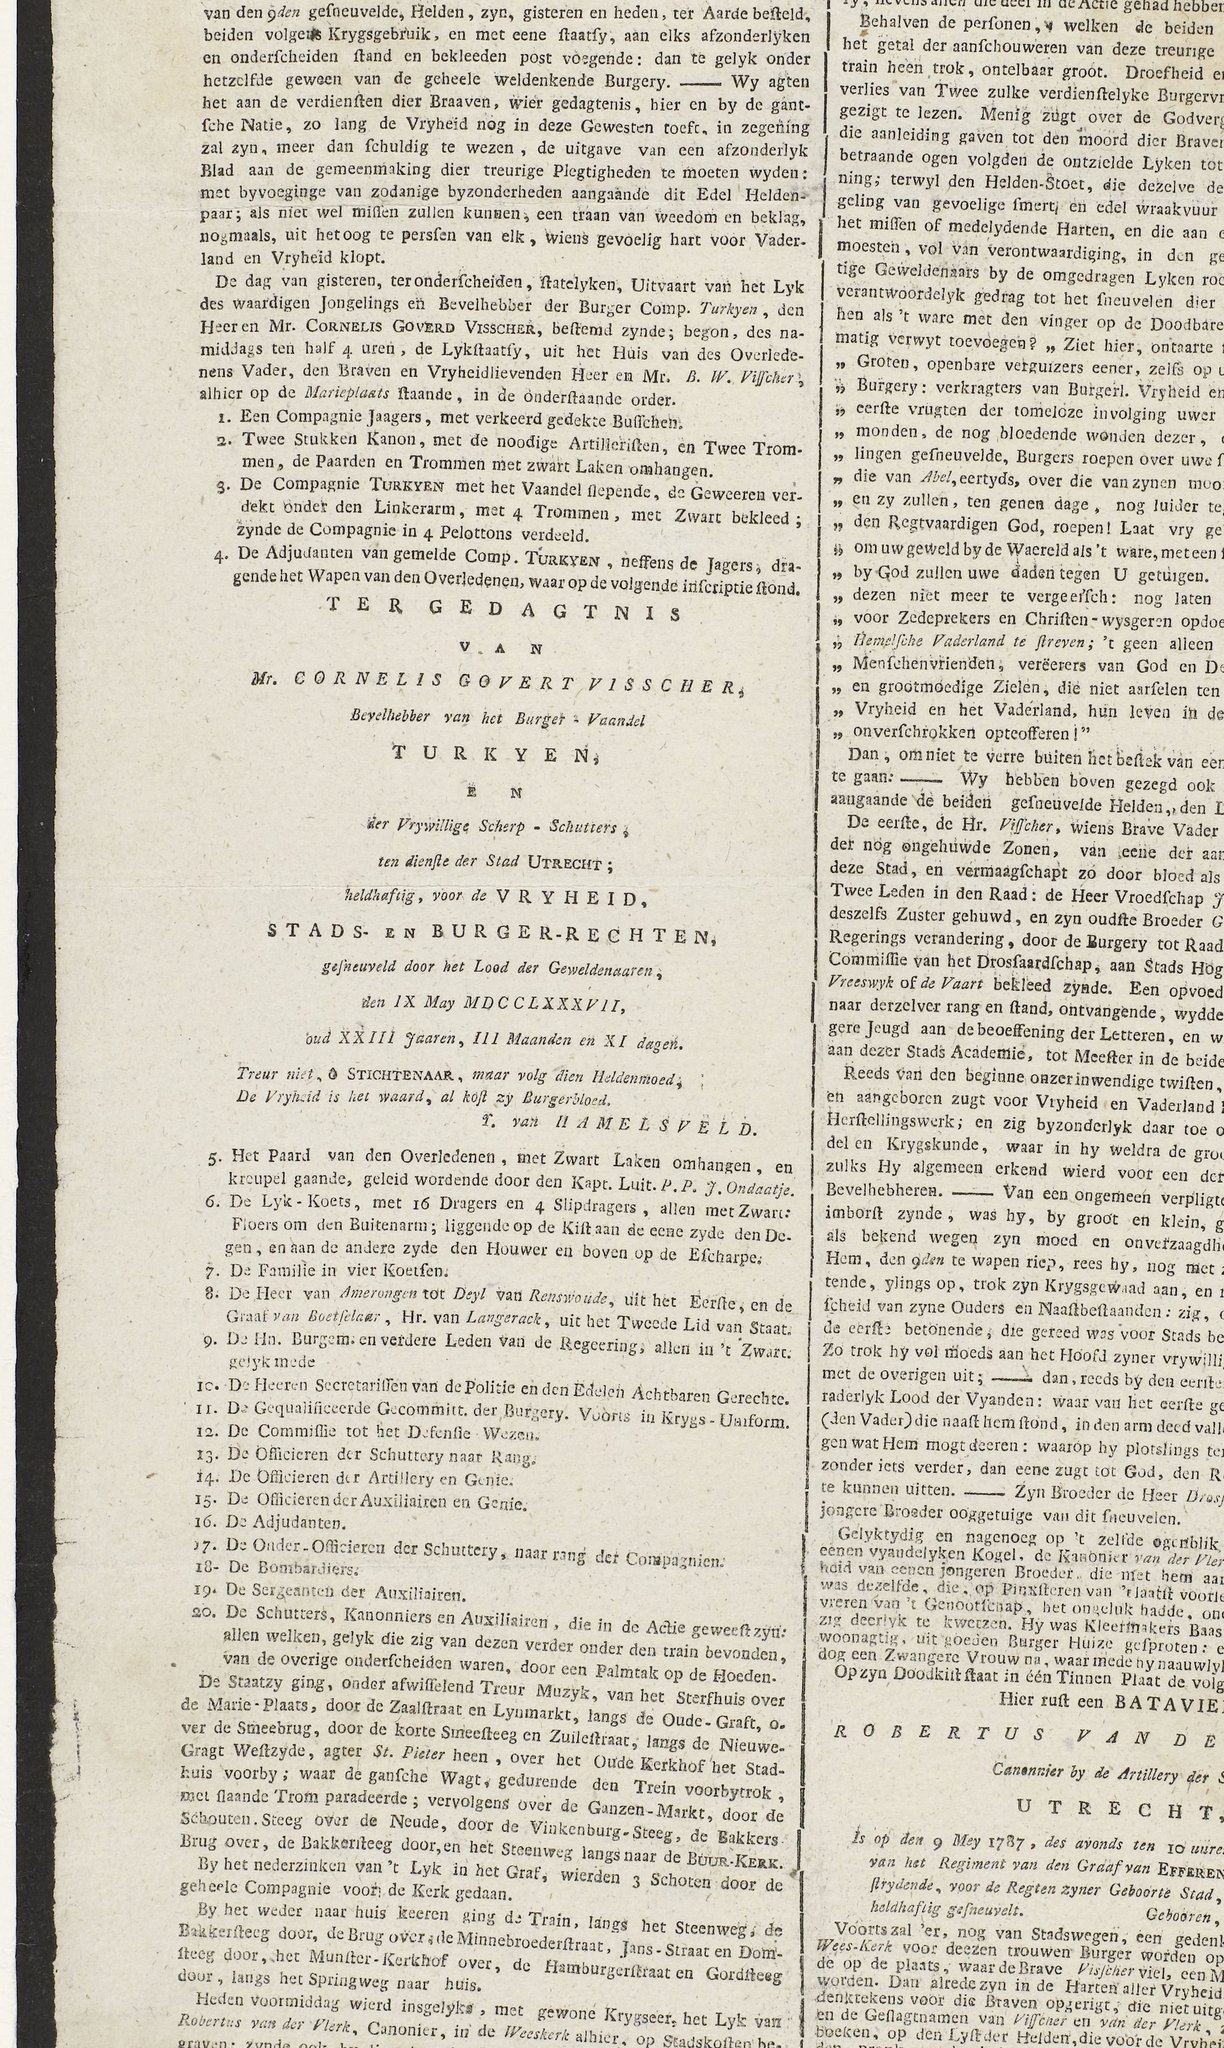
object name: newspaper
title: Extra-Ordinaire Utrechtse Courant. Donderdag den 17 may. Ao. 1787. No. 7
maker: Anonymous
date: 1787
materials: paper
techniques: letterpress printing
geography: utrecht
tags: utrecht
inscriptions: collector's mark: Lugt 2228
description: Aflevering nr. 7 van de Extra-Ordinaire Utrechtse Courant van 17 mei 1787 met een verslag van de begrafenis van Cornelis Govert Visscher (gesneuveld in het gevecht bij Vreeswijk op 9 mei) te Utrecht op 15 mei 1787. Blad gedrukt met zwarte rouwranden, tekst in twee kolommen, bovenaan een het stadswapen van Utrecht.